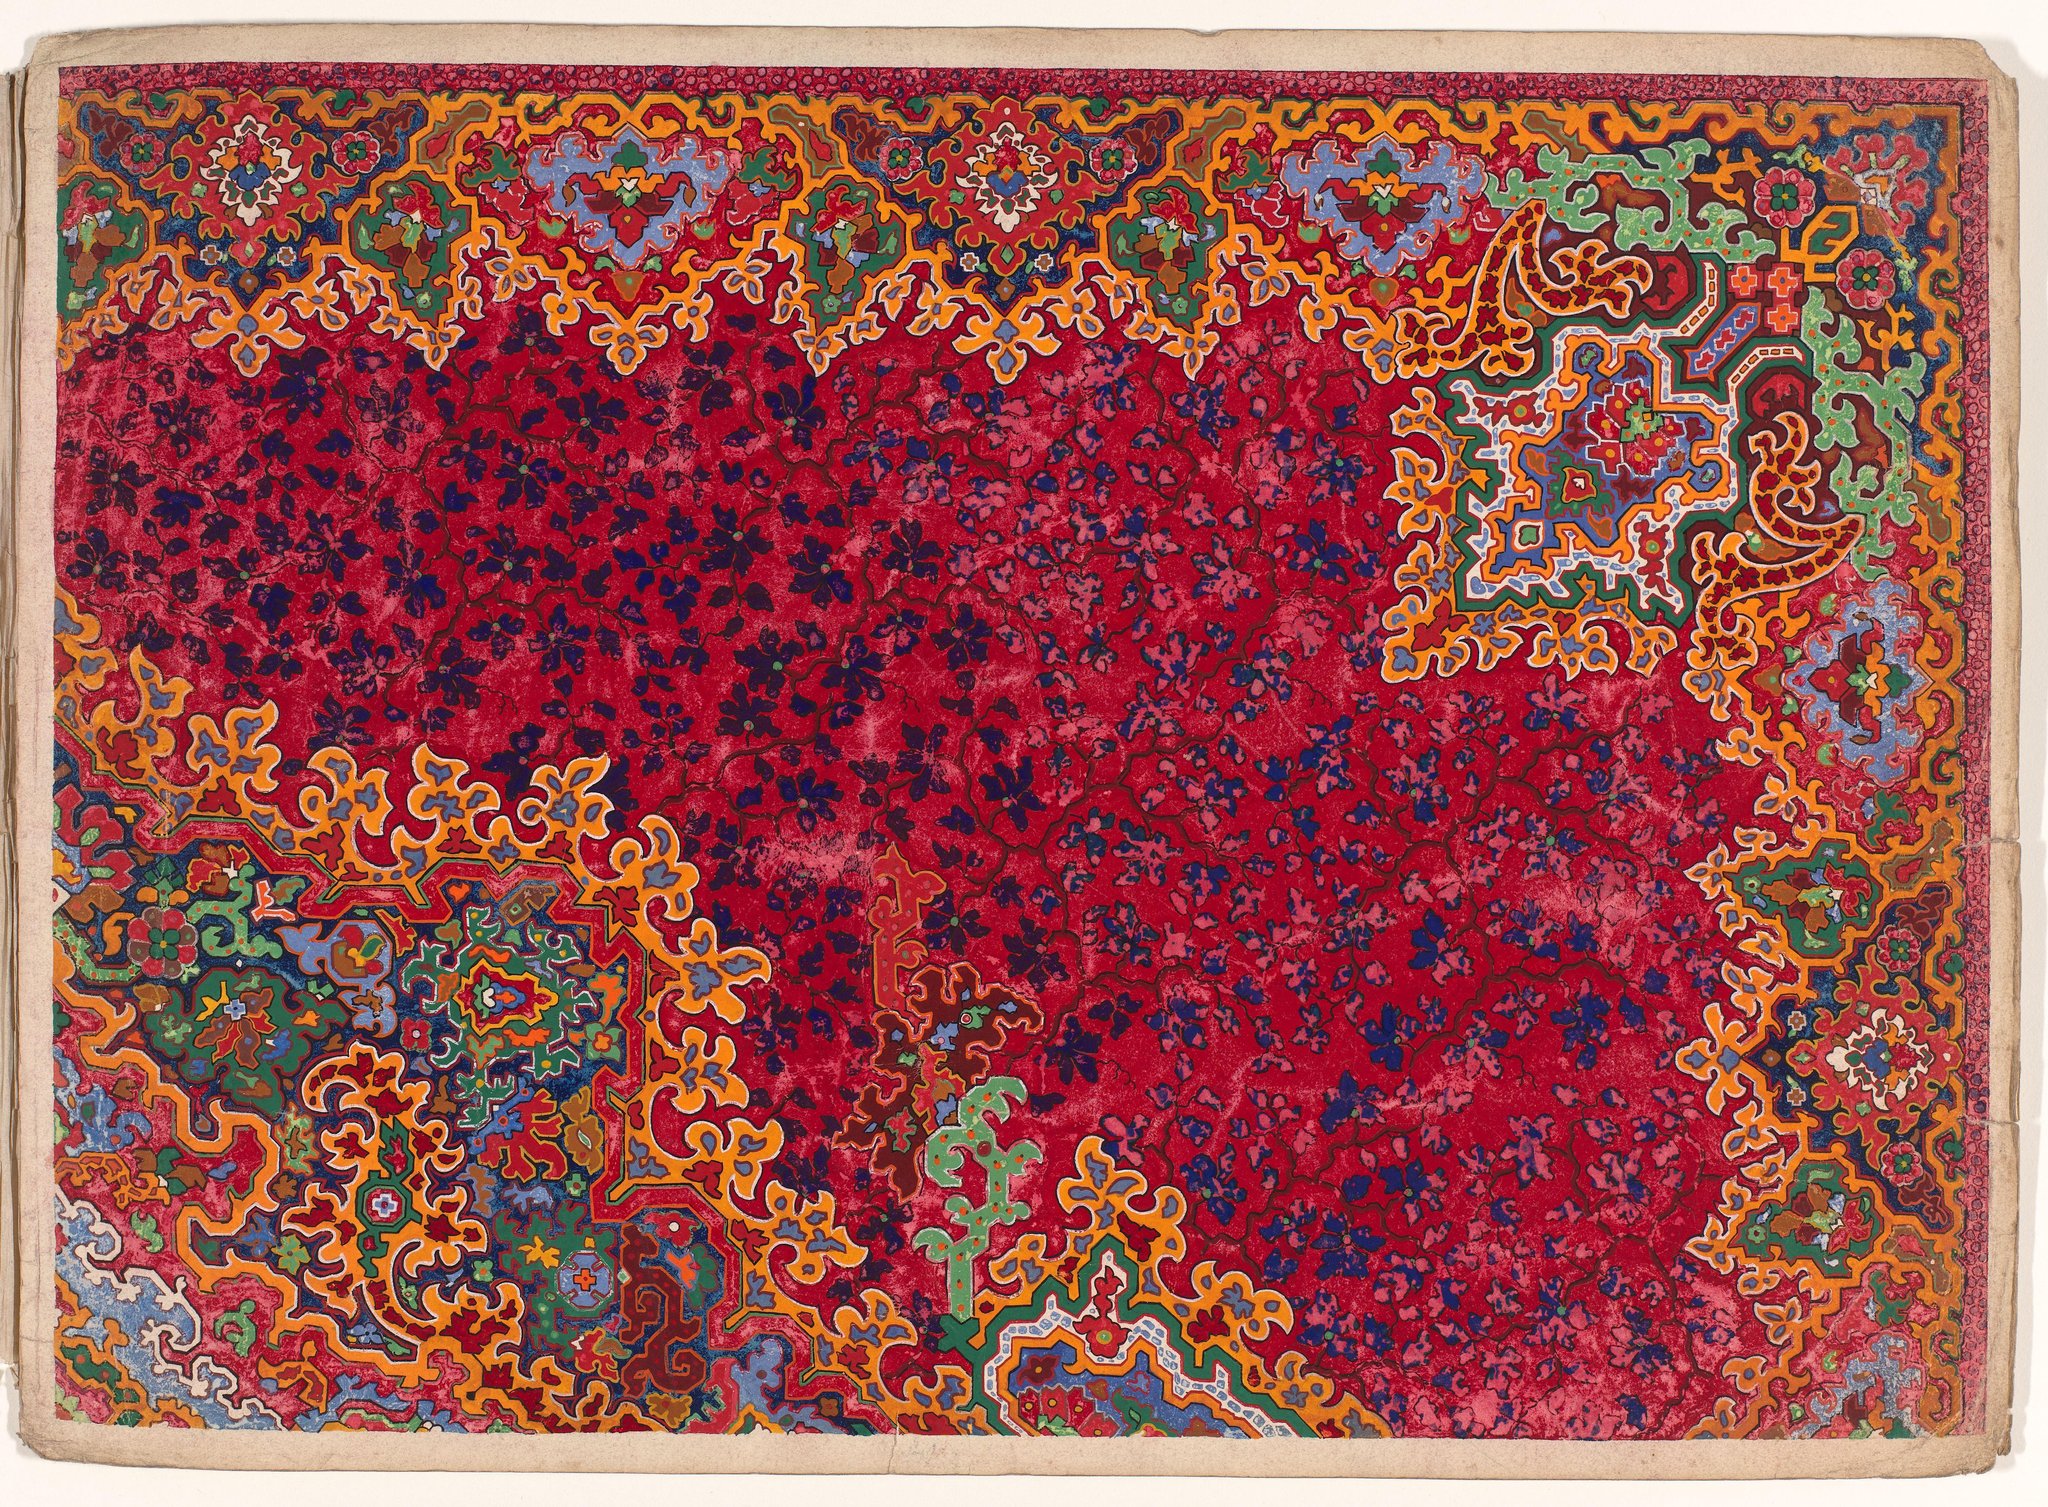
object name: drawing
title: Ontwerp voor een tapijt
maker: Anonymous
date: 1854-1864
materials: gouache, paper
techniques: brush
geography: deventer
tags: ornaments ~ art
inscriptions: inscription: ‘5.52. Ned. [...] is de smalste breedte, waarin deze in 1e kwaliteit kan uitgevoerd worden.’, inscription: ‘Dit gekozen door JJ Claassen/ 1e kwaliteit’, retailer's mark: ‘JHS.’, number: ‘N. 362 A.’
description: De presentatietekeningen BK-1971-77-1 t/m 86 zijn kopieën van de originele ontwerptekeningen. Ze werden gemaakt voor vertegenwoordigers van bijvoorbeeld magazijnen, die ze aan hun klanten konden tonen. De meeste tekeningen tonen een kwart van het dessin inclusief rand, middenpartij (de zogenaamde grond of fond) en centraal medaillon. Door het gebruik van spiegels kan de illusie van het gehele tapijt worden opgeroepen. Een deel van de tekeningen heeft een alfabetische opeenvolgende letter als kenmerk, de andere groep een cijfer.Waarschijnlijk is de reeks dessins met een letter eerder samengesteld dan de genummerde tekeningen.